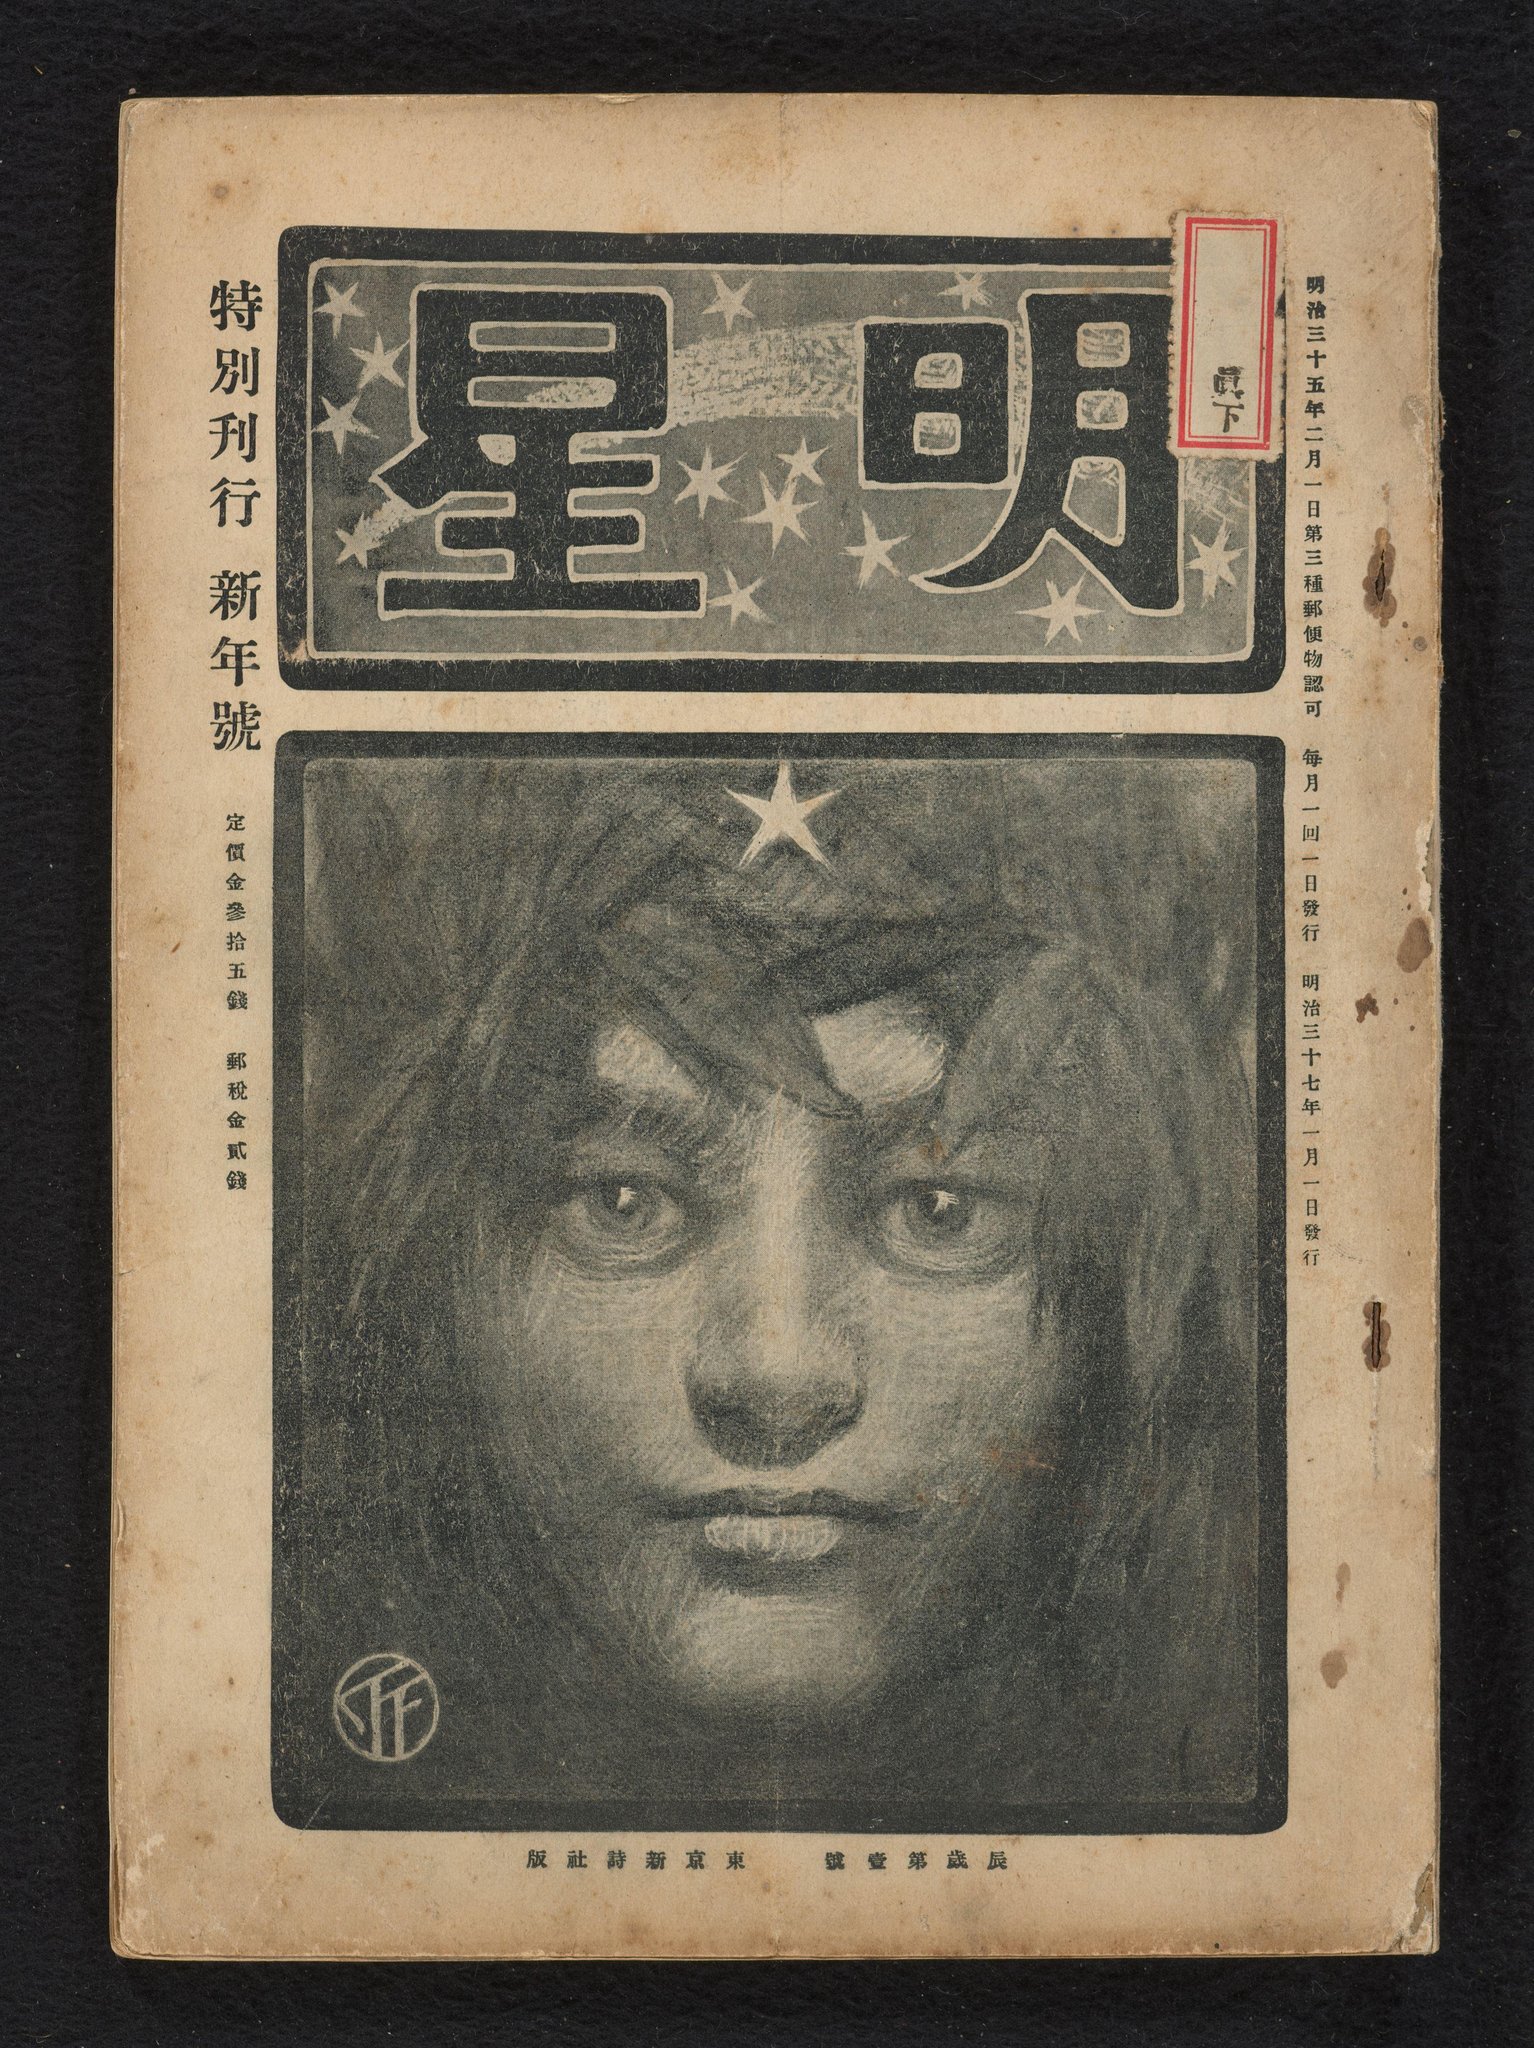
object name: book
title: Ochtendster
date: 1904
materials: paper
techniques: lithograph, woodcut, letterpress printing, offset printed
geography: japan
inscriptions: date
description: Met één pagina met kleurenhoutsnedes van Emil Orlik en drie lithografiën van Nakazawa Hiromitsu, Ishii Hakutie en Sugiura Hisui. Overige illustraties bestaan uit foto reproducties van kunstwerken. Op de achterkant is een foto geplaatst van Yosano Tekkkan en Akiko, de twee redacteuren van het tijdschrift.